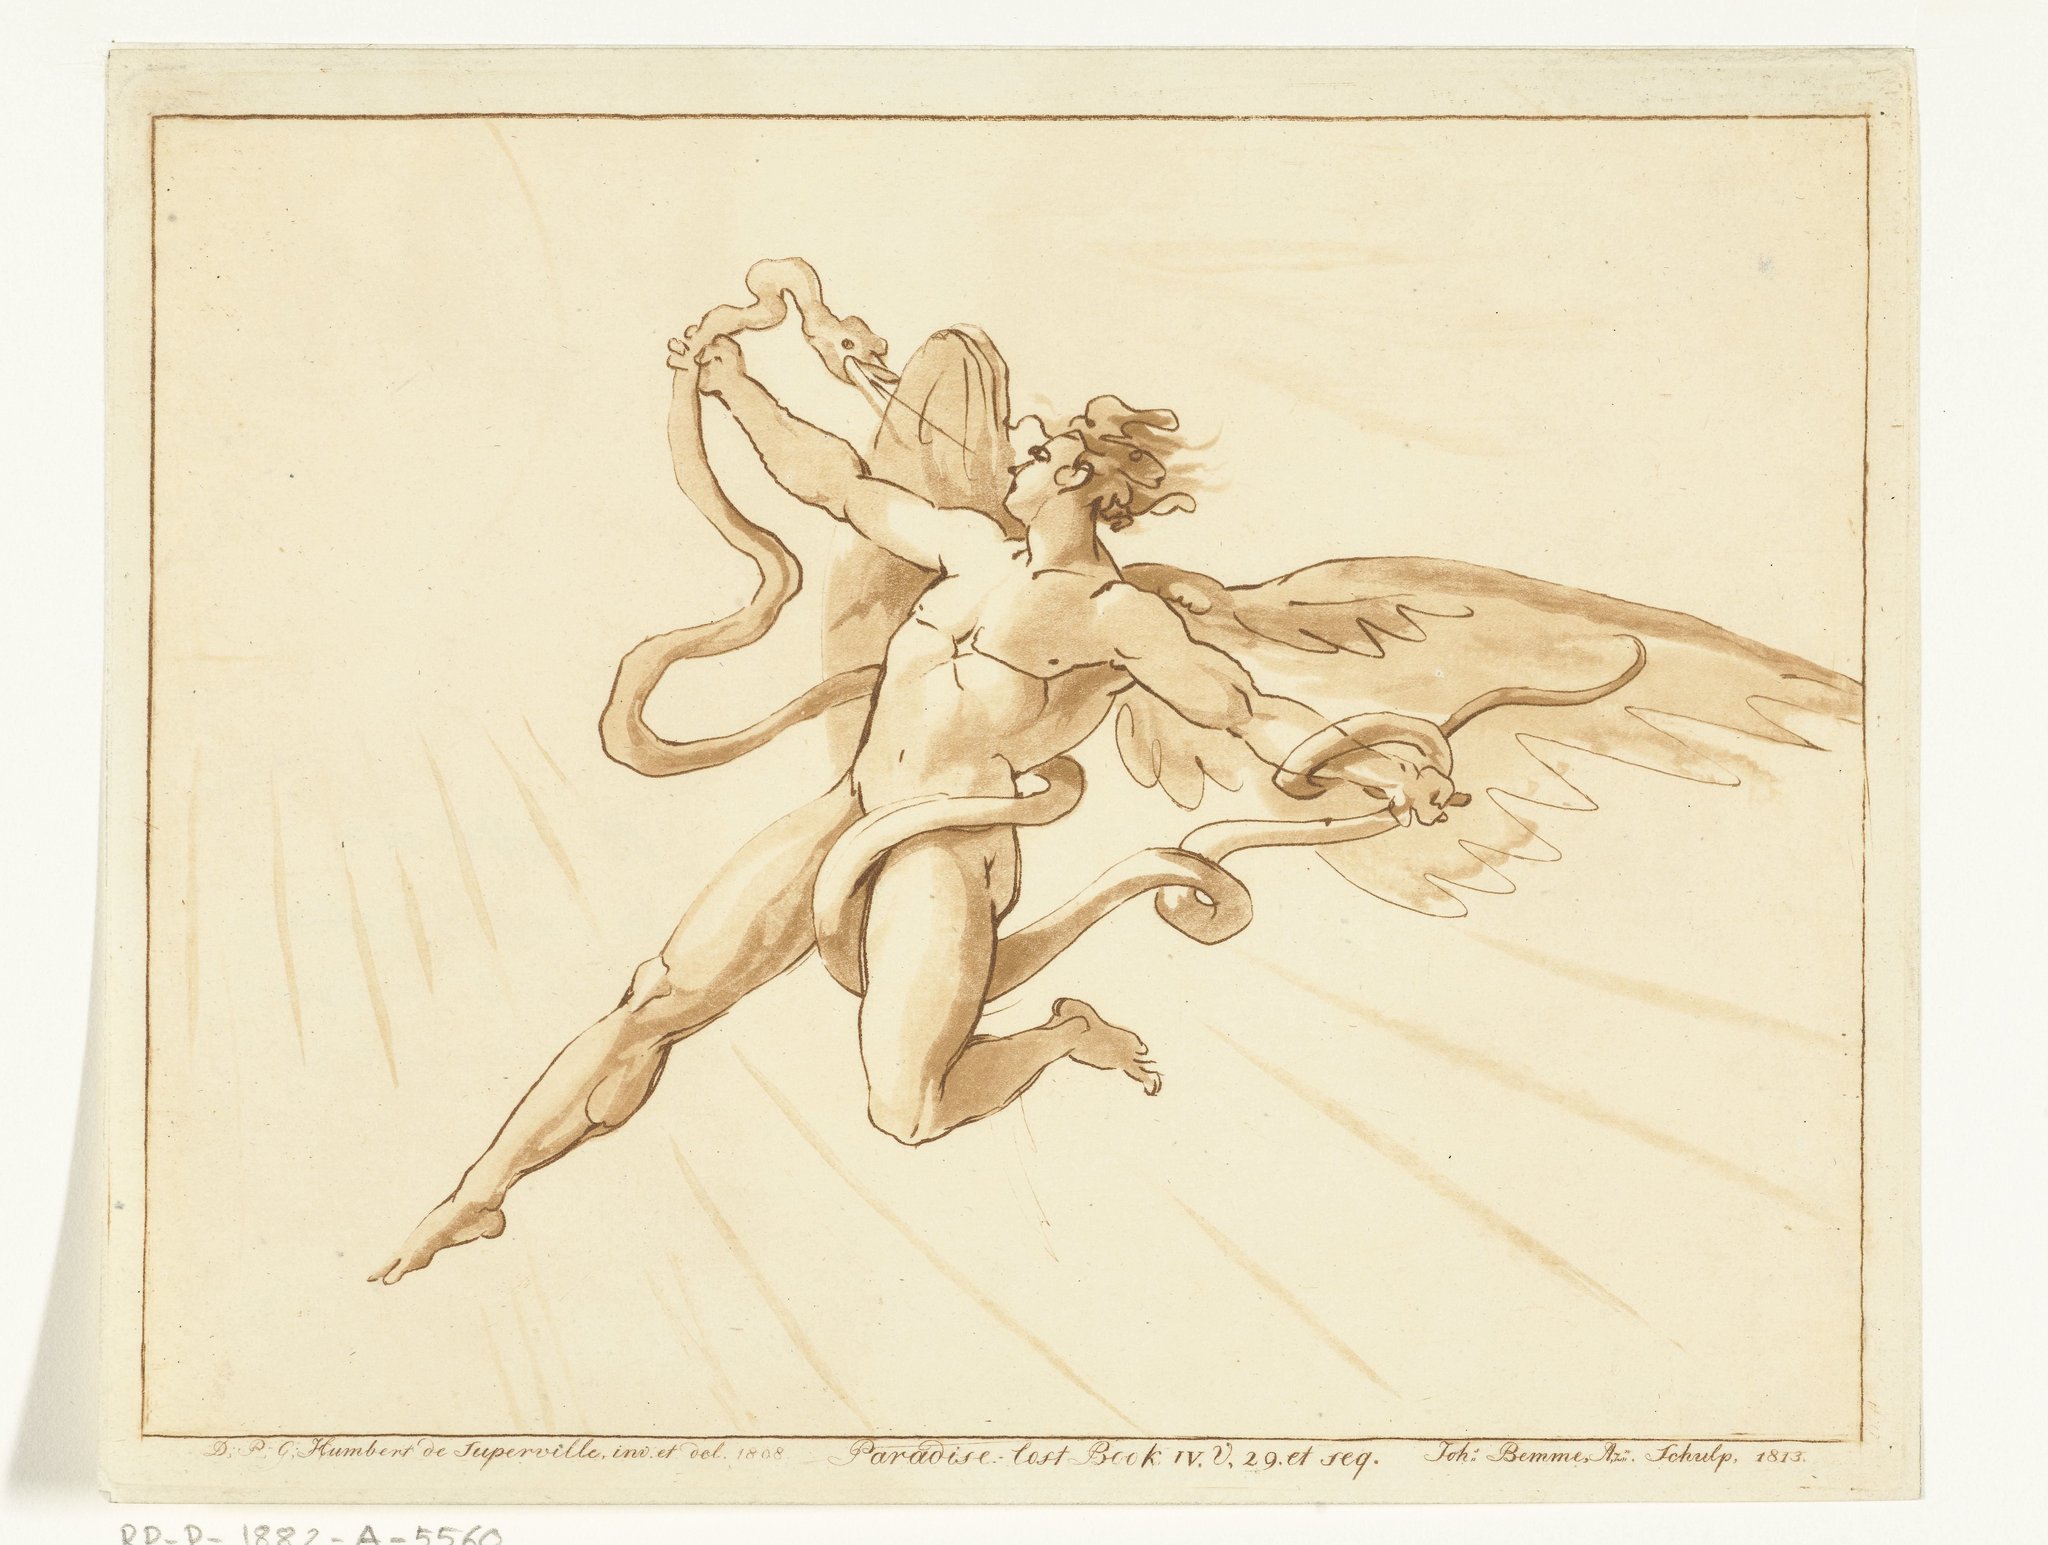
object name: book illustration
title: Een vliegende engel in gevecht met de duivel in de gedaante van een slang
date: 1813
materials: paper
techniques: etching, hand coloring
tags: (scenes from) specific works of literature (with author, title)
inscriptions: collector's mark: Lugt 2228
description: illustratie voor: John Milton, Paradise lost, boek IV, v. 29.